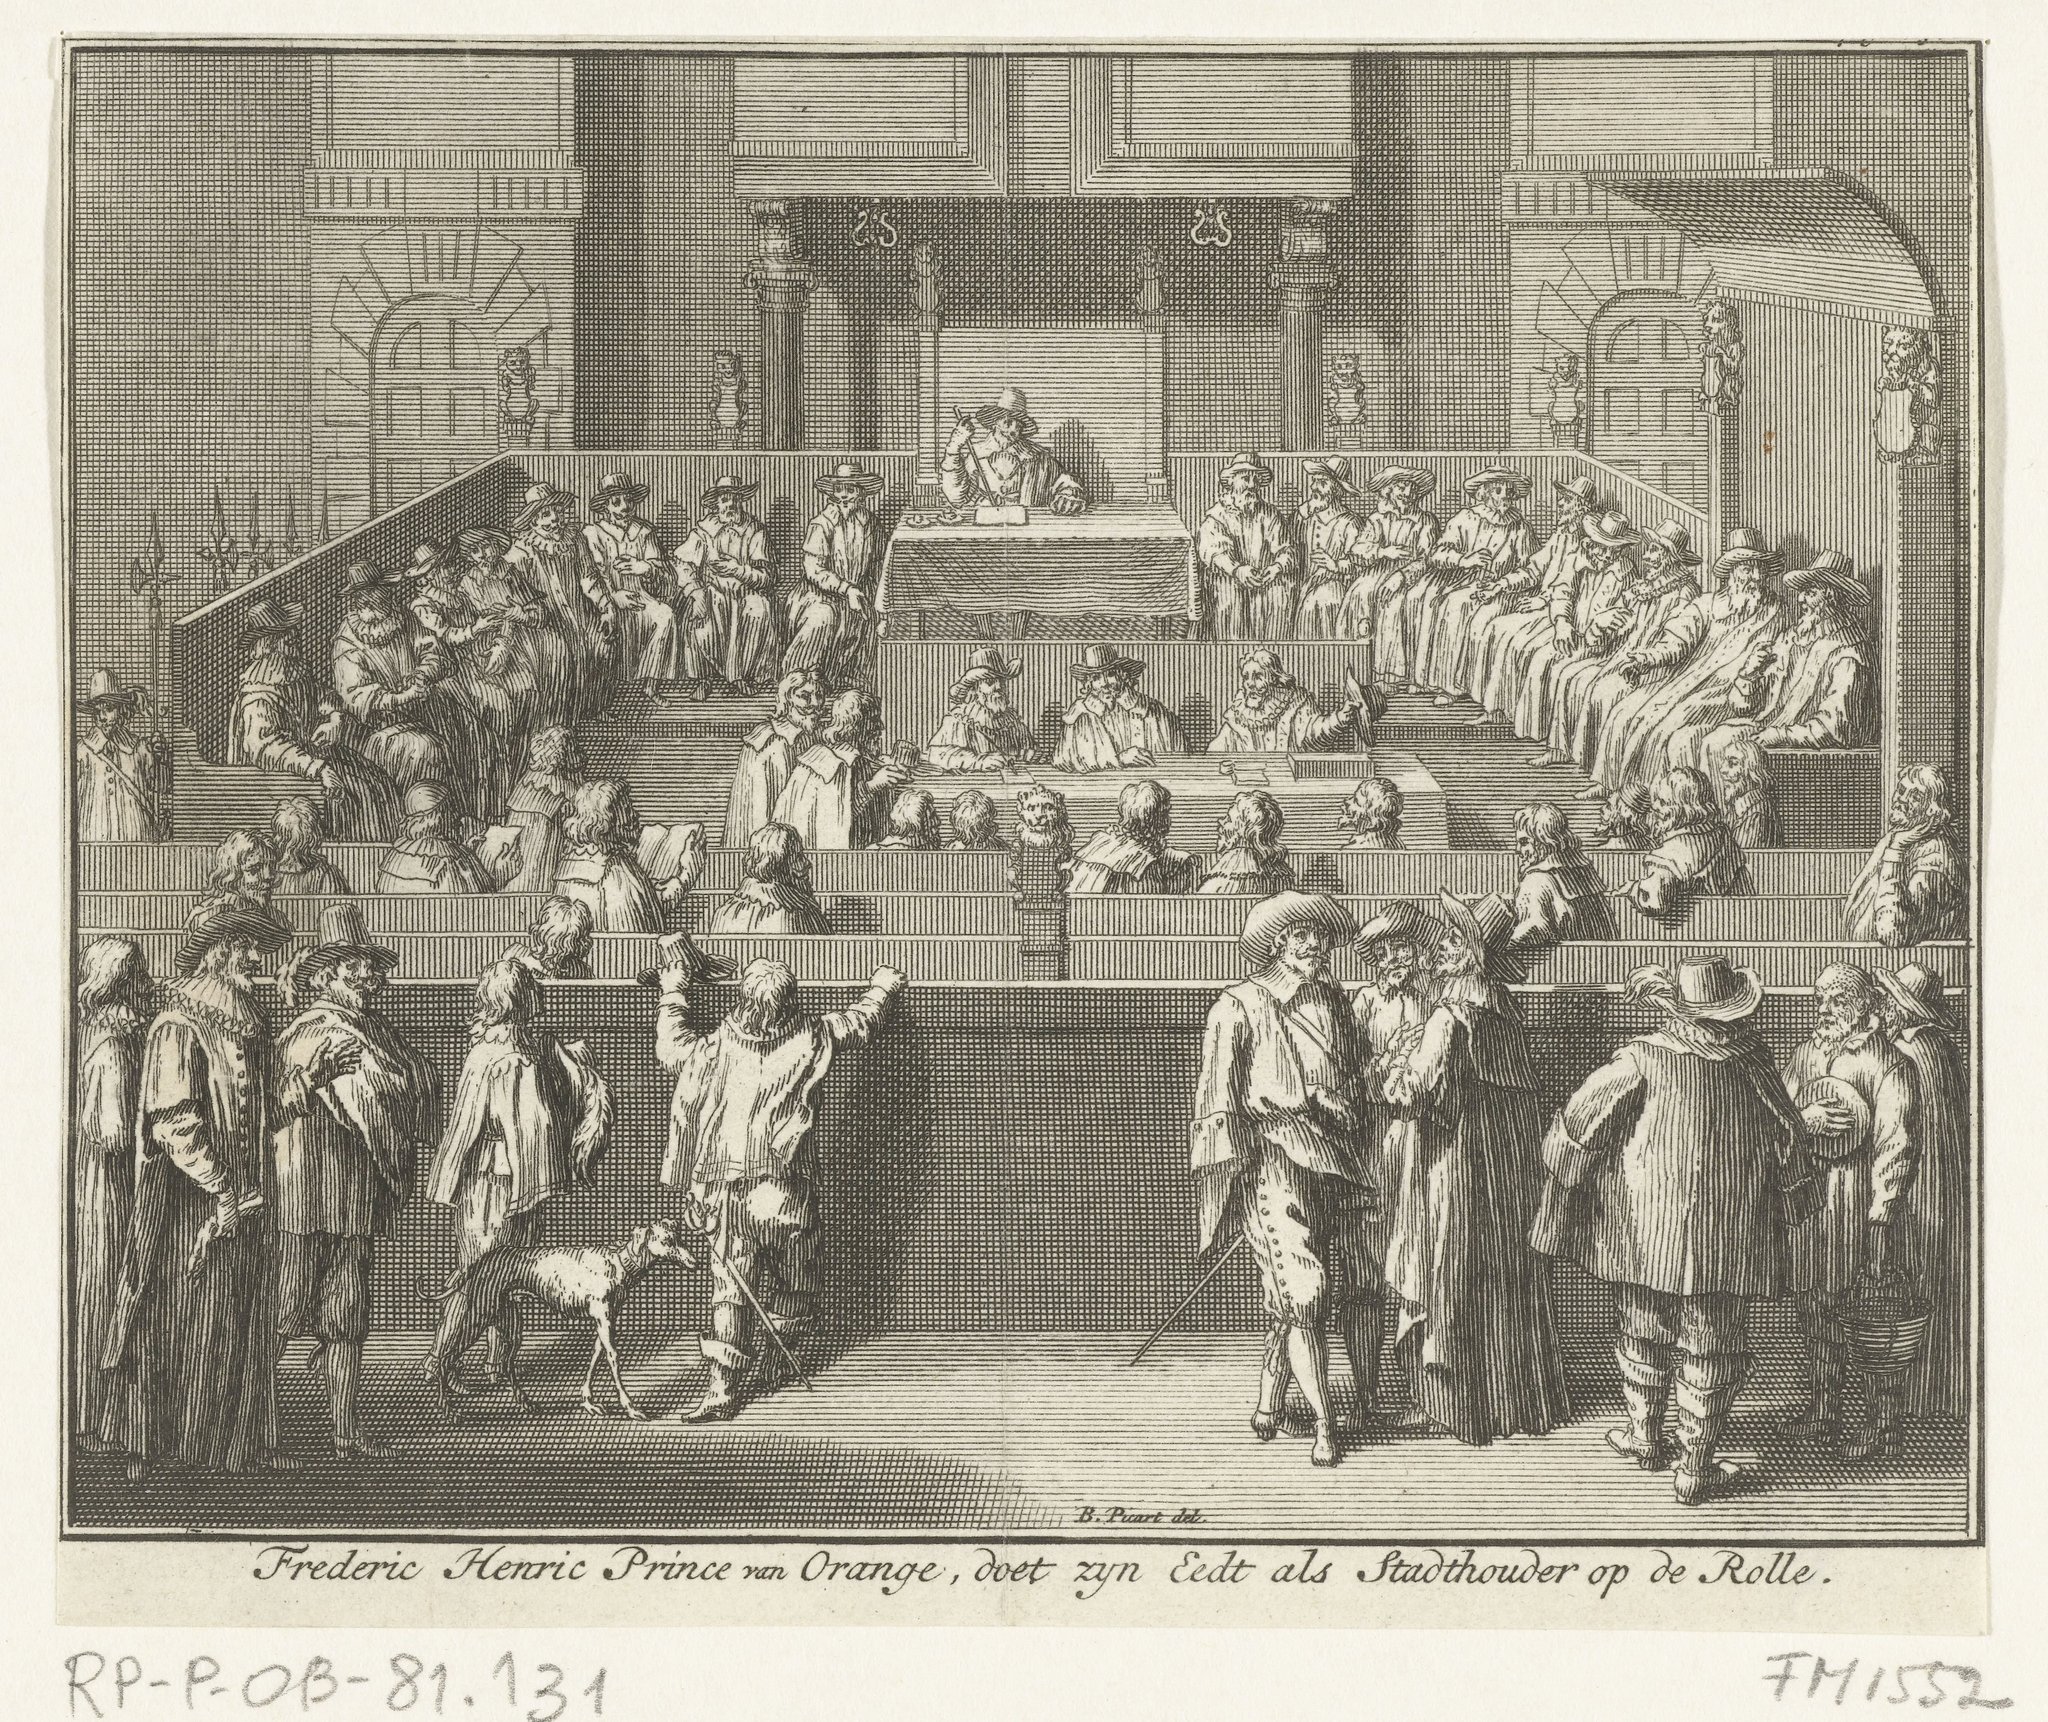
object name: print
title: Frederic Henric Prince van Orange, doet zyn Eedt als Stadthouder op de Rolle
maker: bernard picart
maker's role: draughtsman, print maker, publisher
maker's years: 1673-1733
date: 1732-1733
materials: paper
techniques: engraving, etching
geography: northern netherlands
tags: delft, frederick henry (prince of orange), new ruler taking the oath, popular representation ~ government, the hague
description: Kopie naar de prent in: I. Commelin, Frederick Hendrick van Nassauw Prince van Orangien : zyn leven en bedryf, Jodocus Janssonius, Amsterdam 1651, fol. 7 (FMH 1549). Gebruikt (met een Franse titel) als illustratie in: Memoires de Frederic Henri Prince d'Orange. Qui contiennent ses Expéditions Militaires depuis 1621. jusqua l'Année 1646. Enrichis du portrait du prince et de figures, representant ses actions les plus memorables dessinées et gravées par Bernard Picart, Pierre Humbert, Amsterdam 1733. Exemplaar in de collectie van de Rijksmuseum Research Library met signatuur 550 E 7.